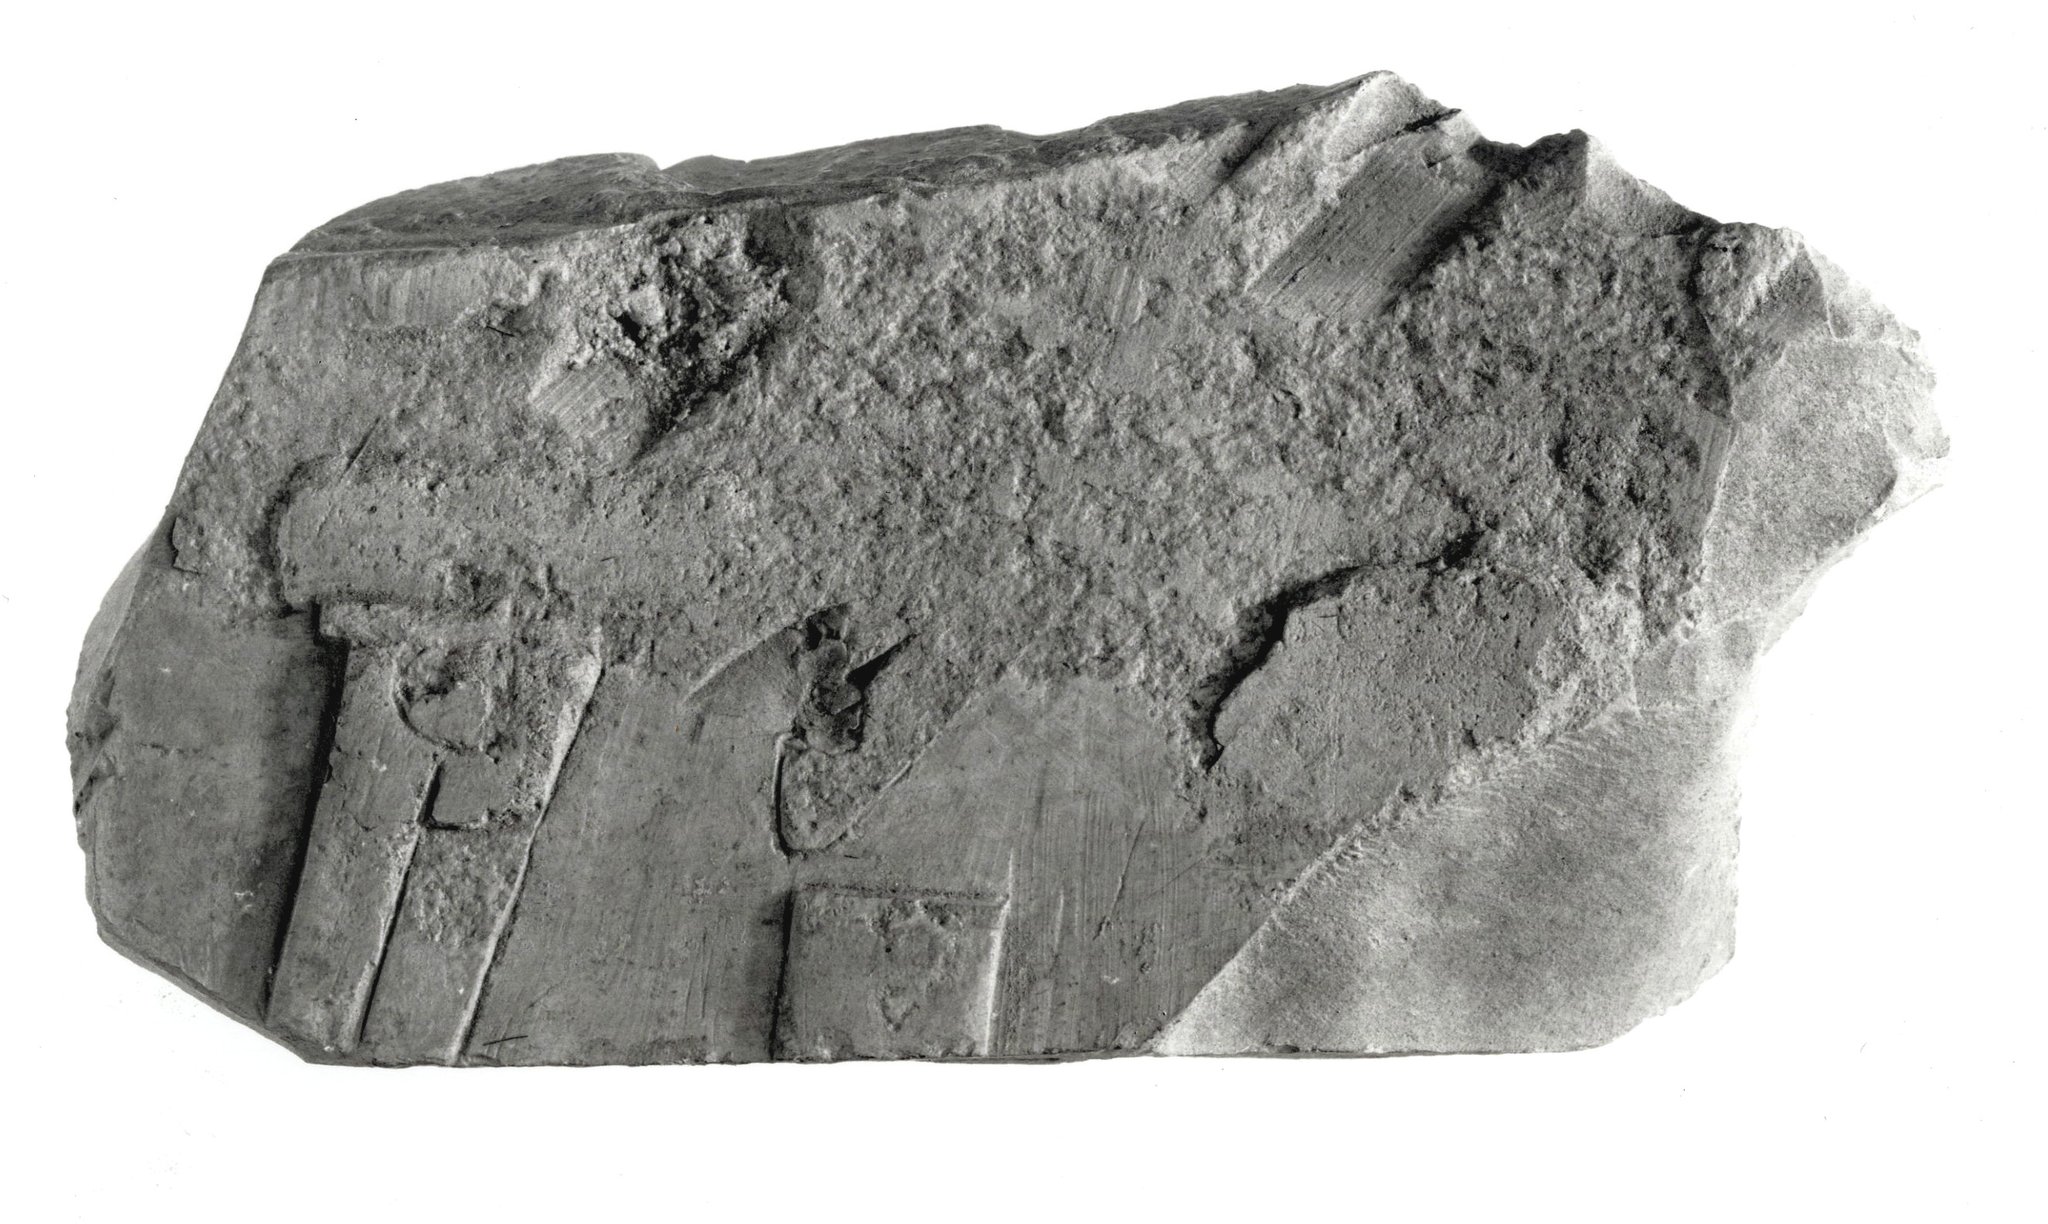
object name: relief, tomb of nespekashuty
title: Raised relief fragment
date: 664-610 BCE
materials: limestone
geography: egypt